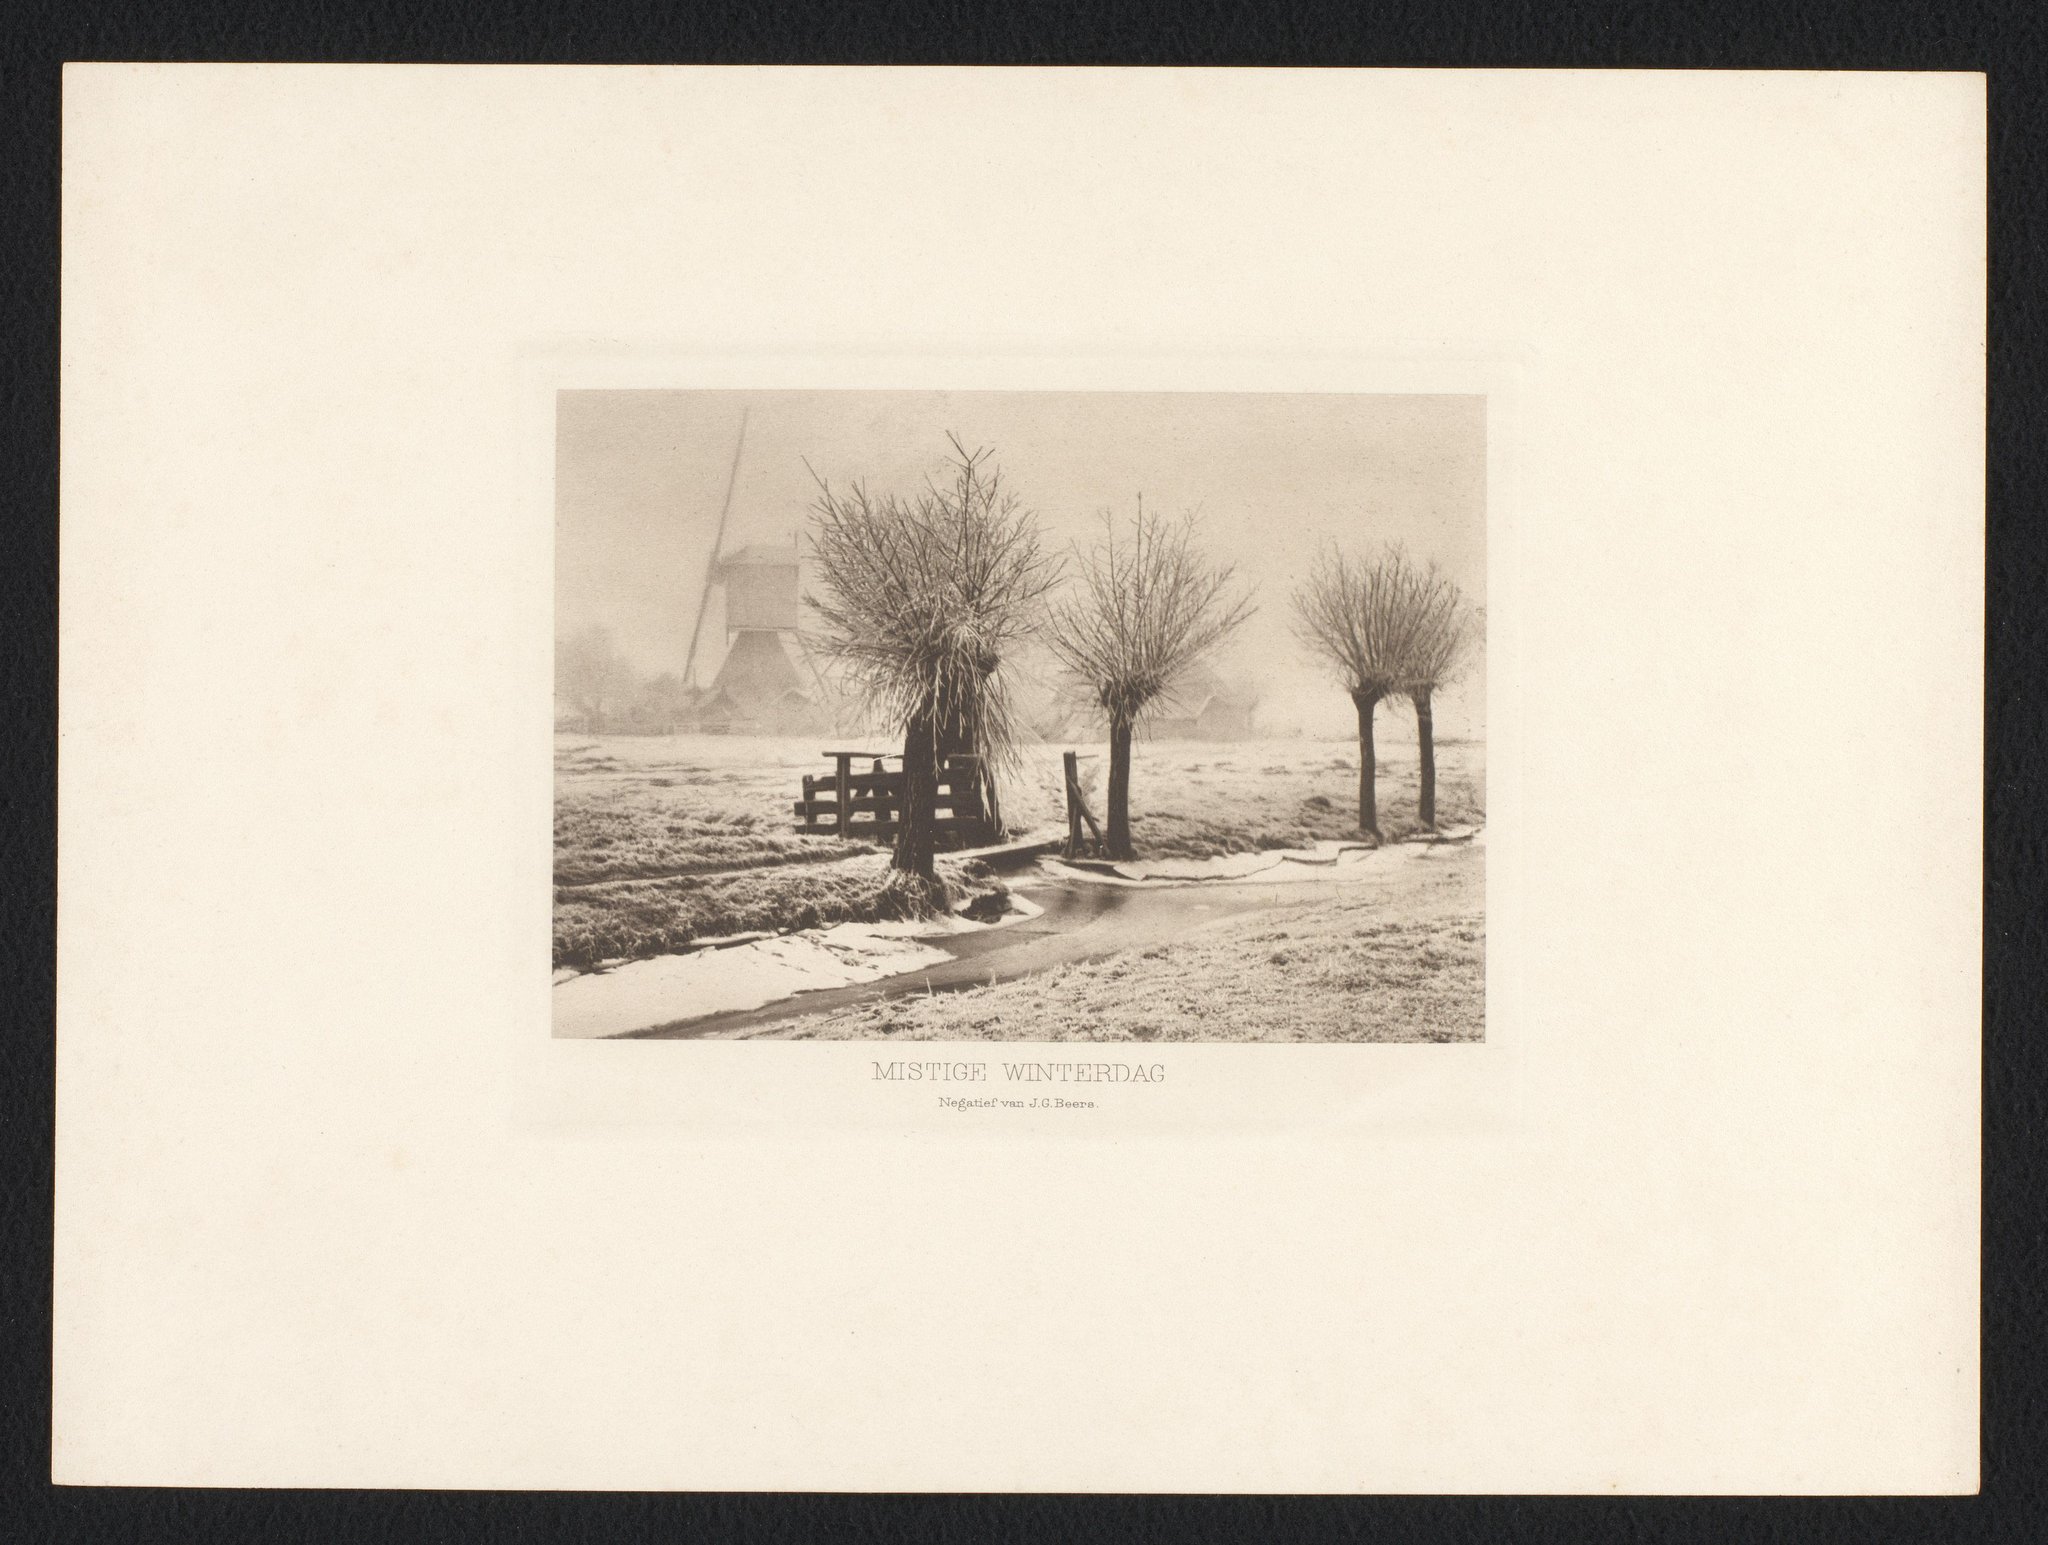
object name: photomechanical print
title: Mistige winterdag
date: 1899-1904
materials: paper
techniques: photoaquatint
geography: netherlands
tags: trees, meadow, pasture, windmill in landscape, agriculture, small canal, ditch